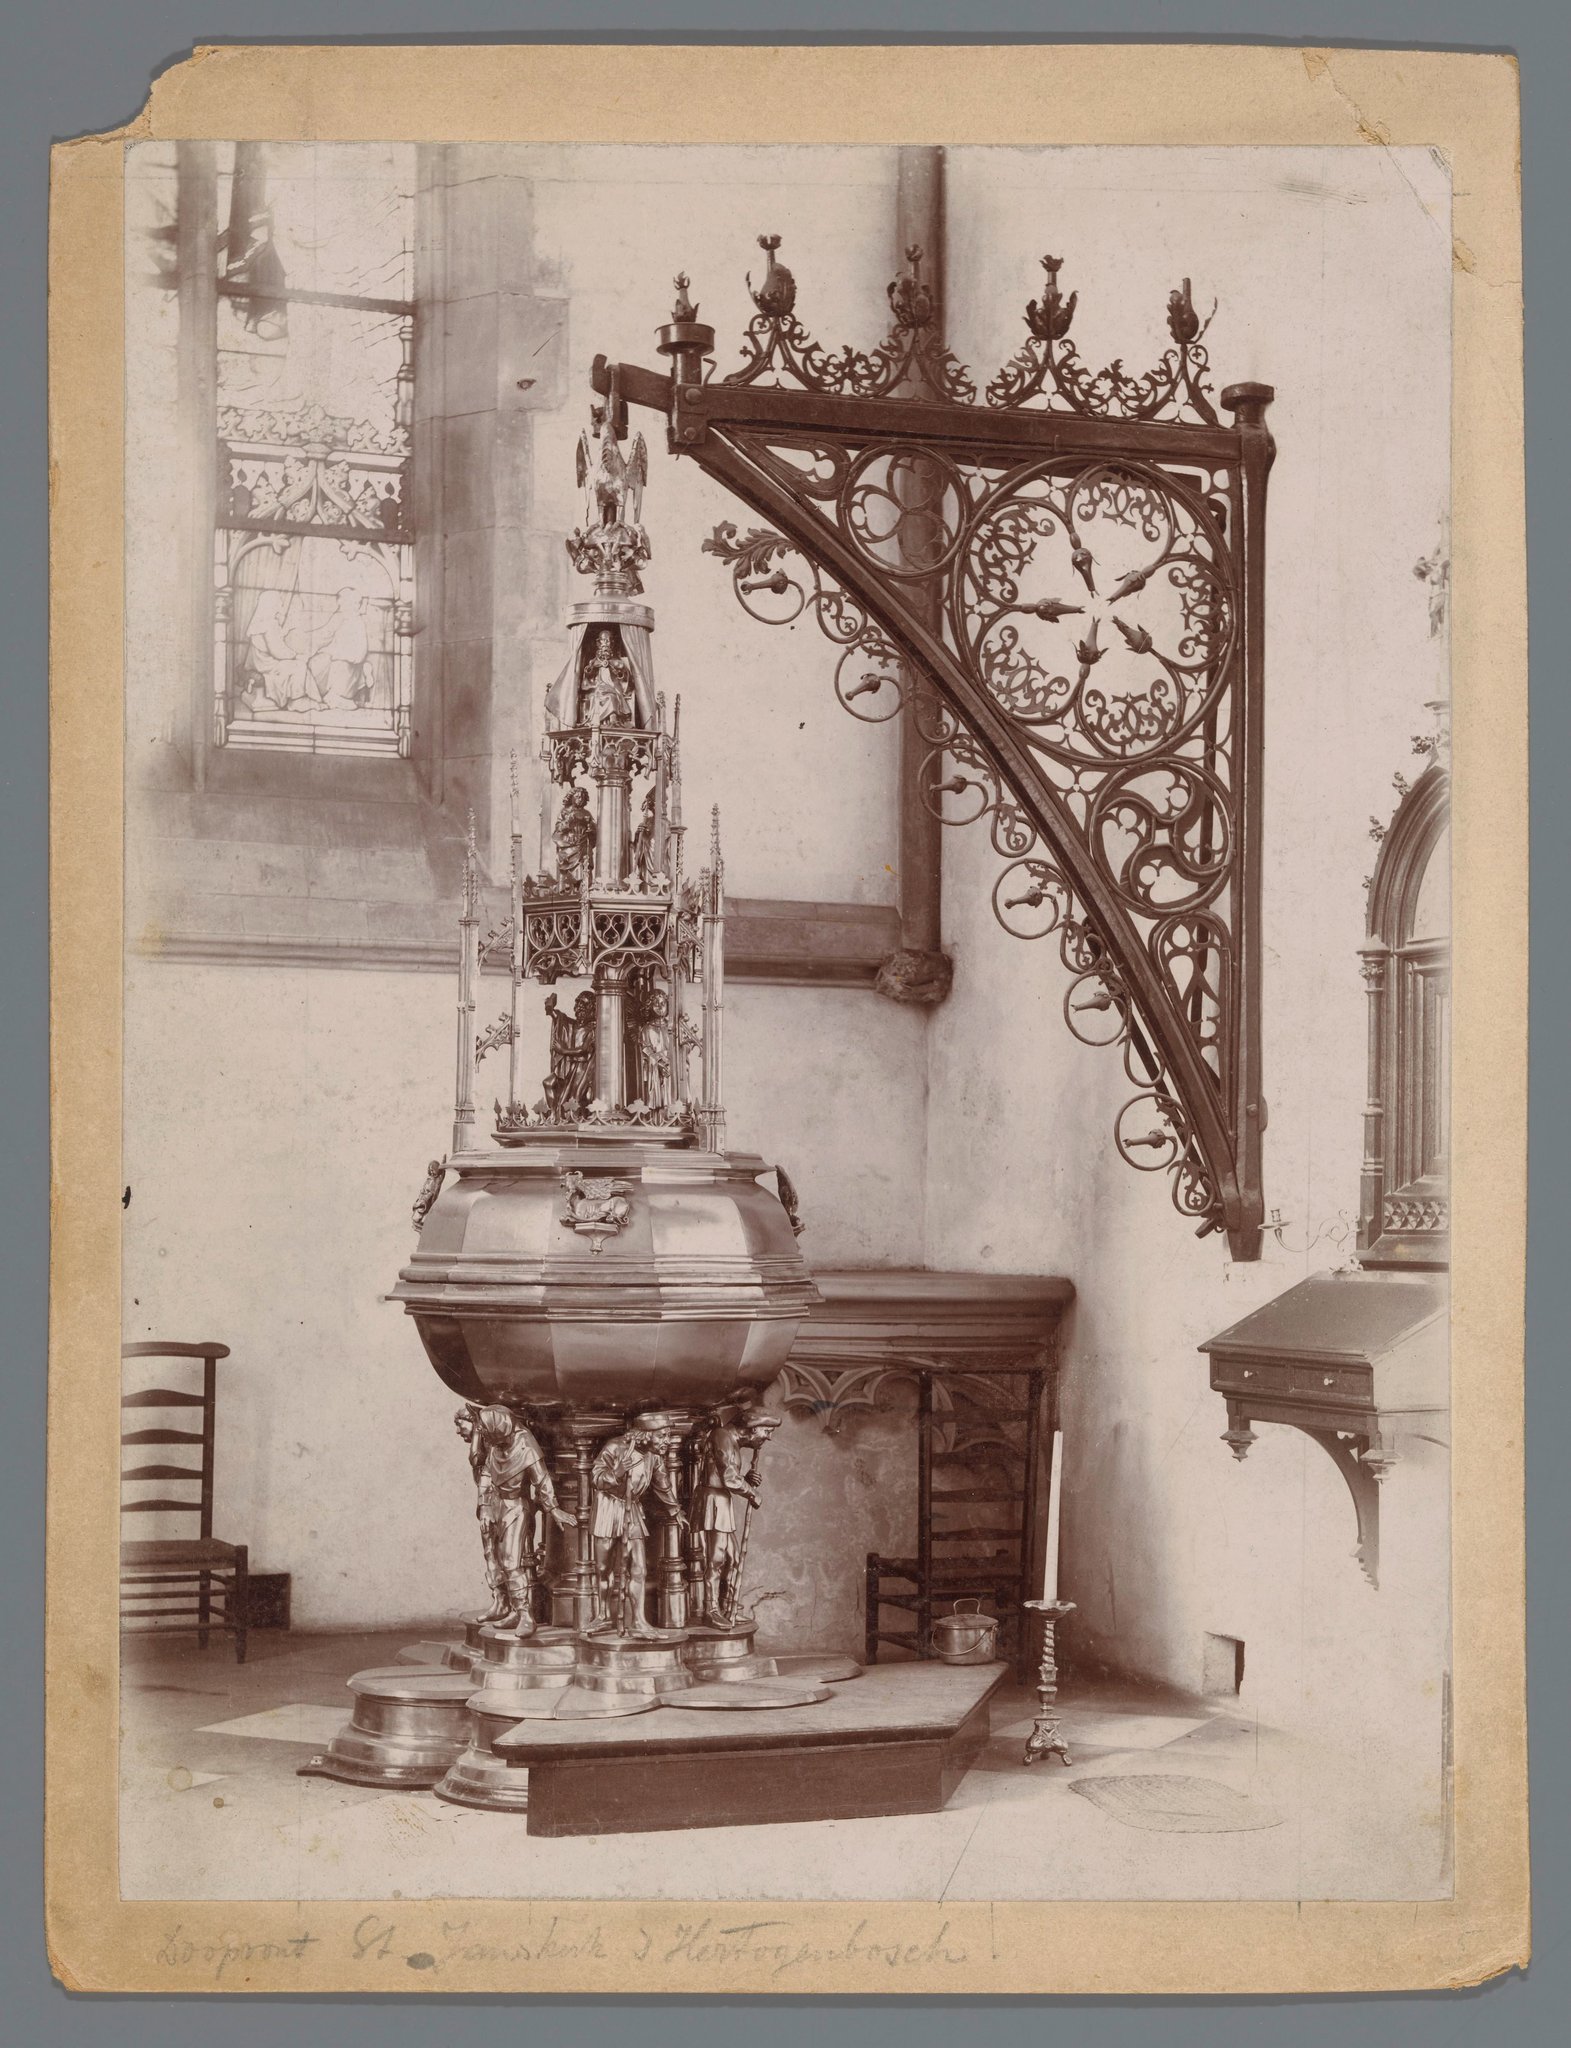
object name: photograph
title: Doopvont in de Sint-Janskathedraal te 's-Hertogenbosch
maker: Anonymous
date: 1875-1900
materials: cardboard, photographic support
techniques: daylight paper print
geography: sint-janskathedraal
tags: baptismal font, parts of church interior: chapel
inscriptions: collector's mark: Lugt 3937, inscription: ‘Doopvont St. Janskerk 's Hertogenbosch’